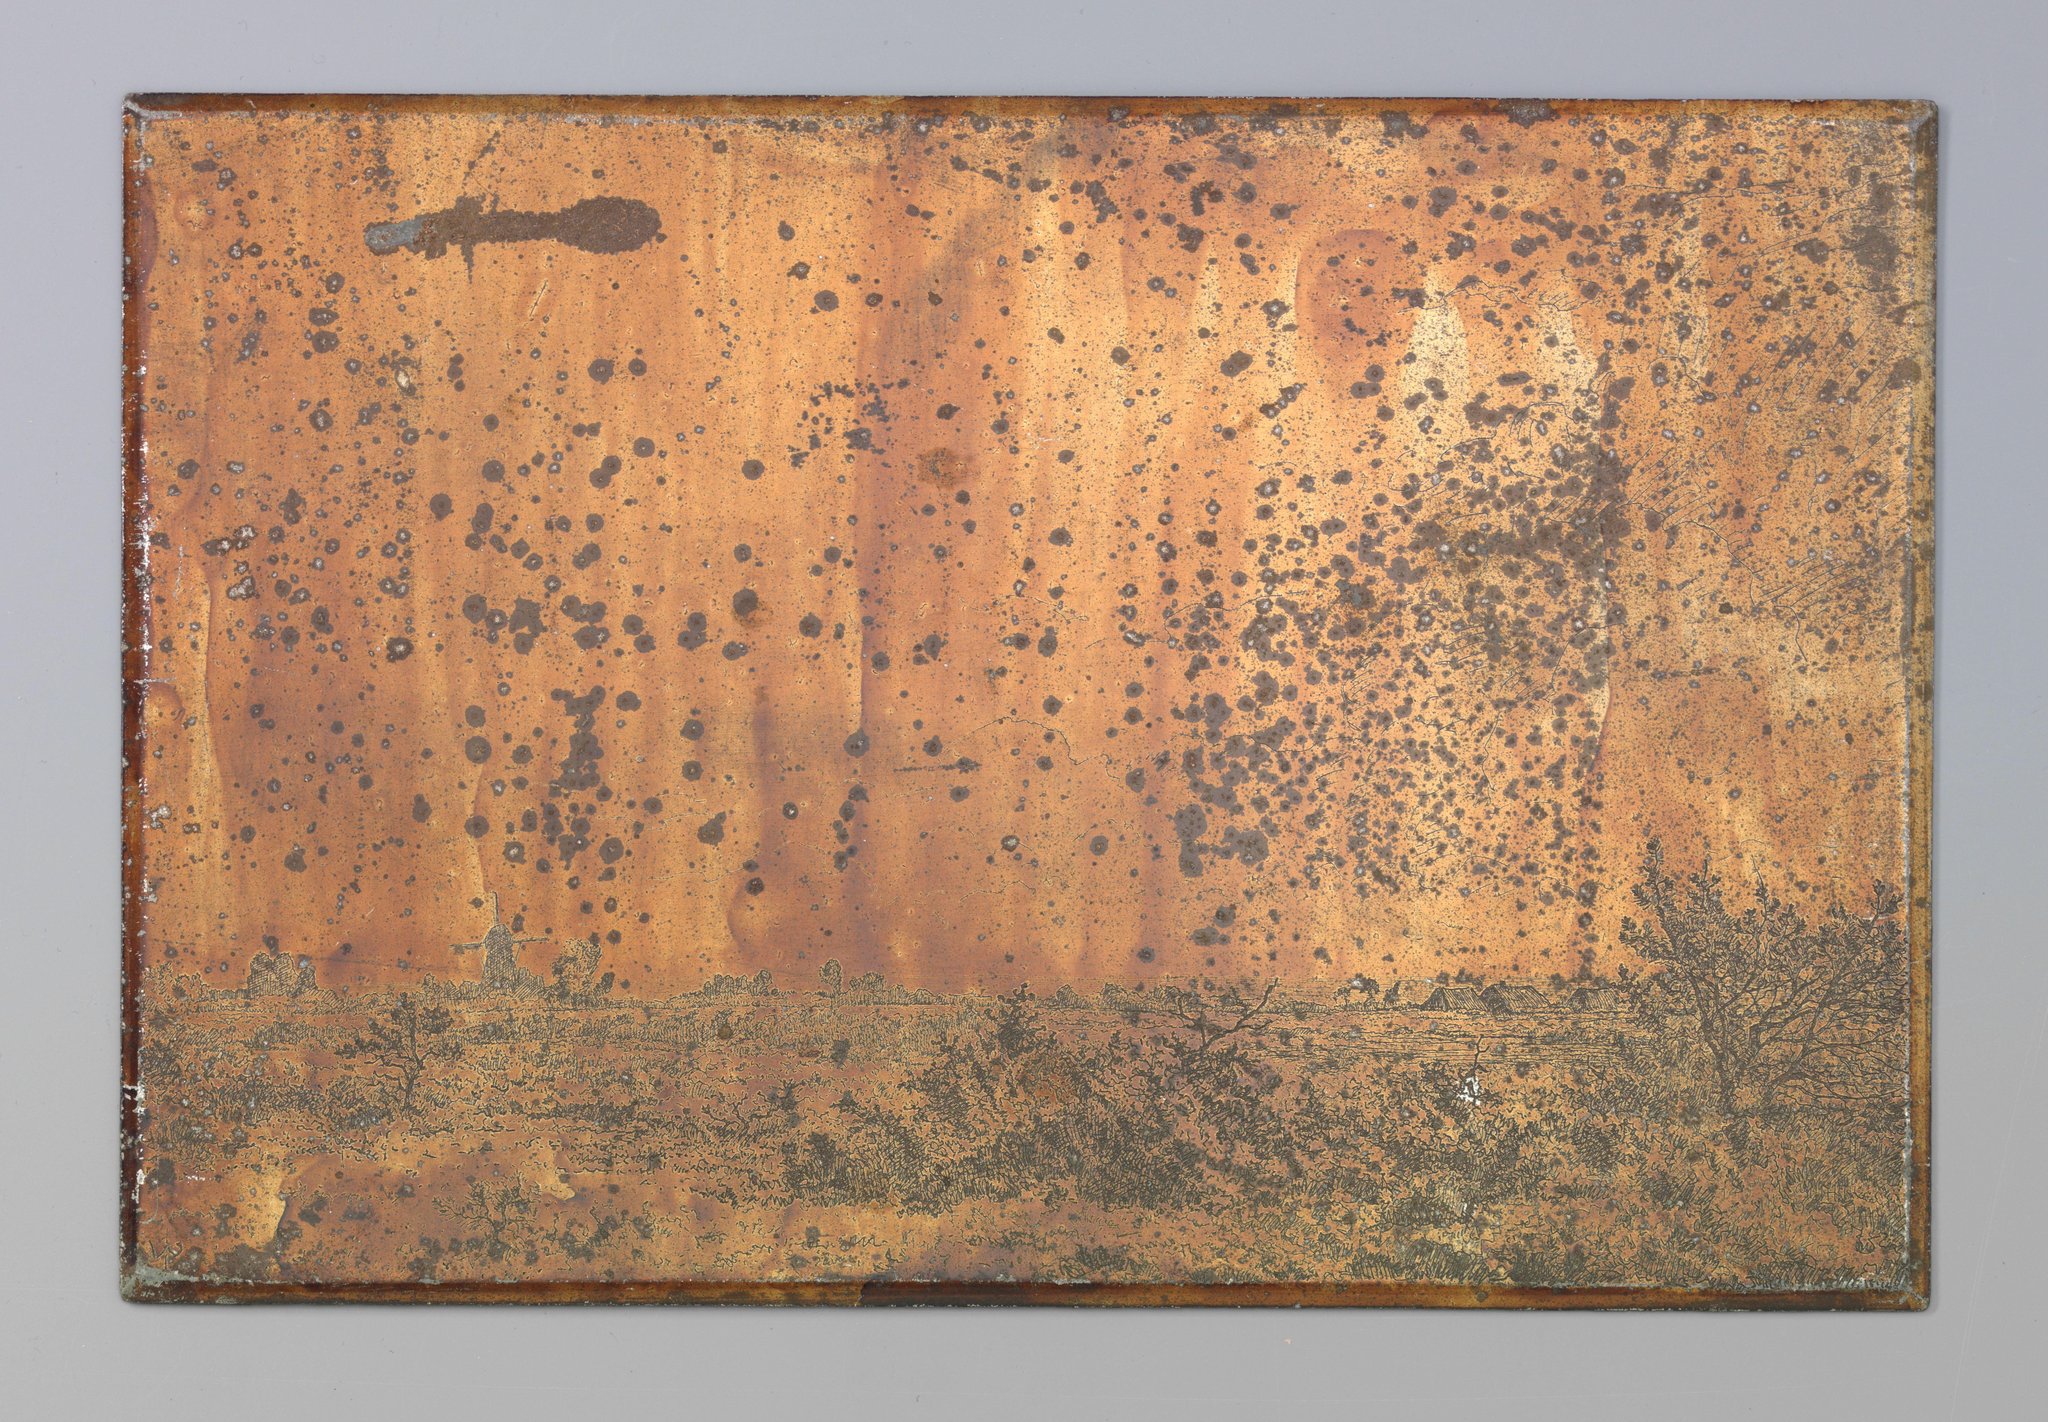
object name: zinkplaat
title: Landschap met struikgewas en molen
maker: Anonymous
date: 1850-1899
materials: zinc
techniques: etching